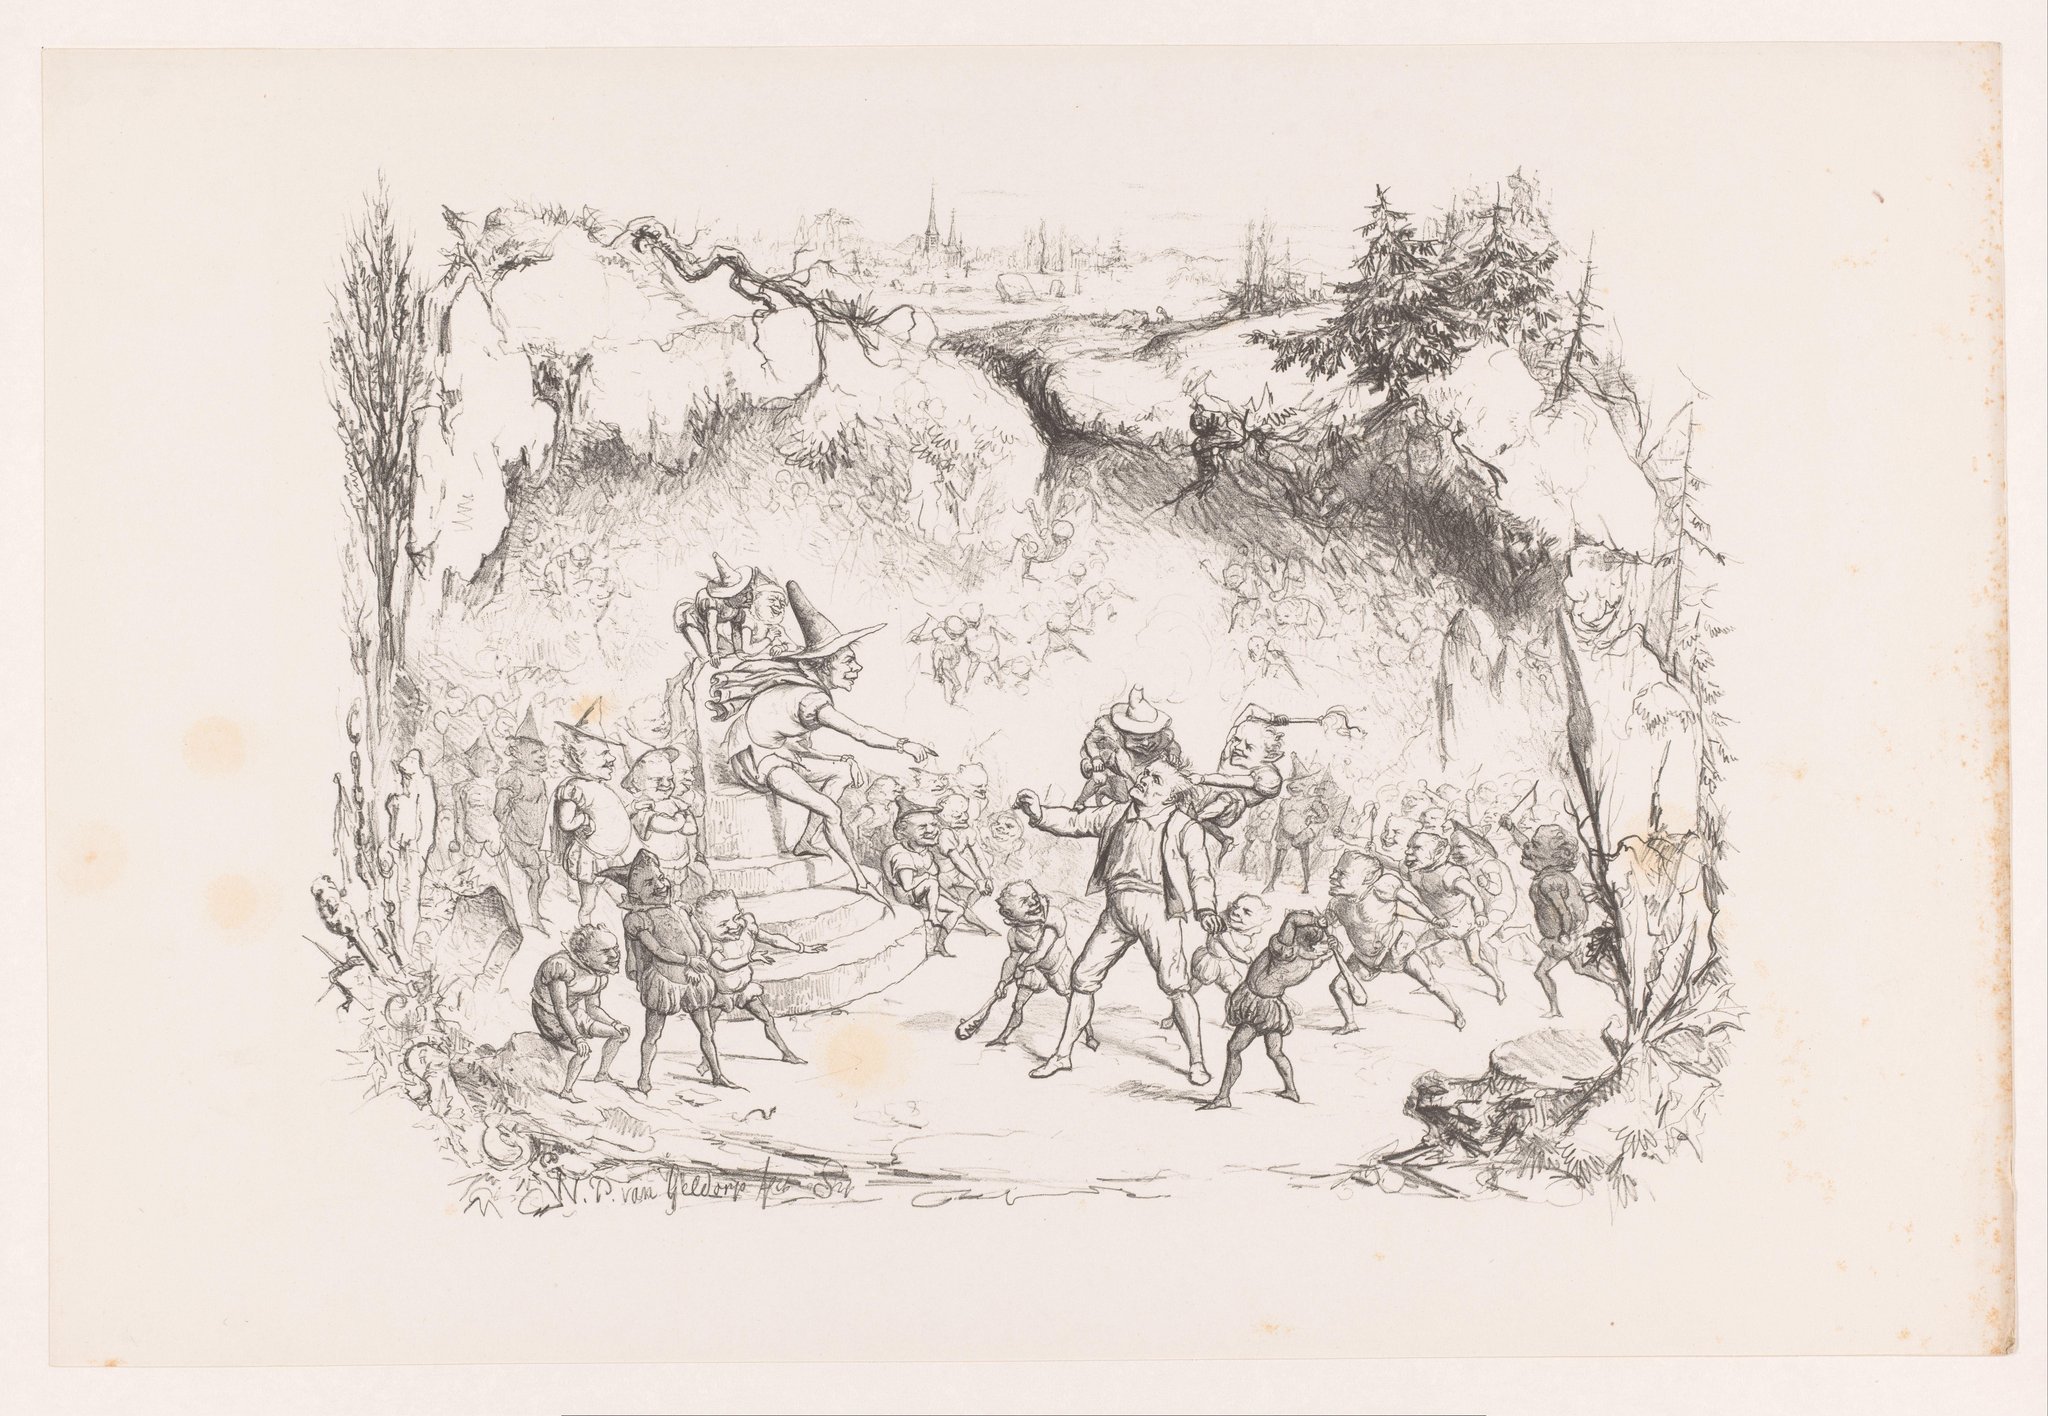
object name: print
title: Gabriël Grub in de afgrond door de Kabouters gestraft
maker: wilhelmus petrus van geldorp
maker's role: print maker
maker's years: 1832-1900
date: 1872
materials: paper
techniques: lithograph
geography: rotterdam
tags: underground shelters, spirit of the earth, gnome, troll, corporal punishment in public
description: Gabriël Grub is een personage uit The Pickwick Papers, geschreven door Charles Dickens in 1836. Grub is de literaire voorloper van Ebenezer Scrooge en het verhaal vertoont veel gelijkenissen met A Christmas Carol. Grub is door de koning van de kabouters ontvoerd naar zijn ondergrondse schuilplaats. Daar kijgt hij scènes te zien die zijn gevoel over de mensheid en het kerstfeest ten goede veranderen. Tussen de scènes door wordt hij door de kabouters geslagen.